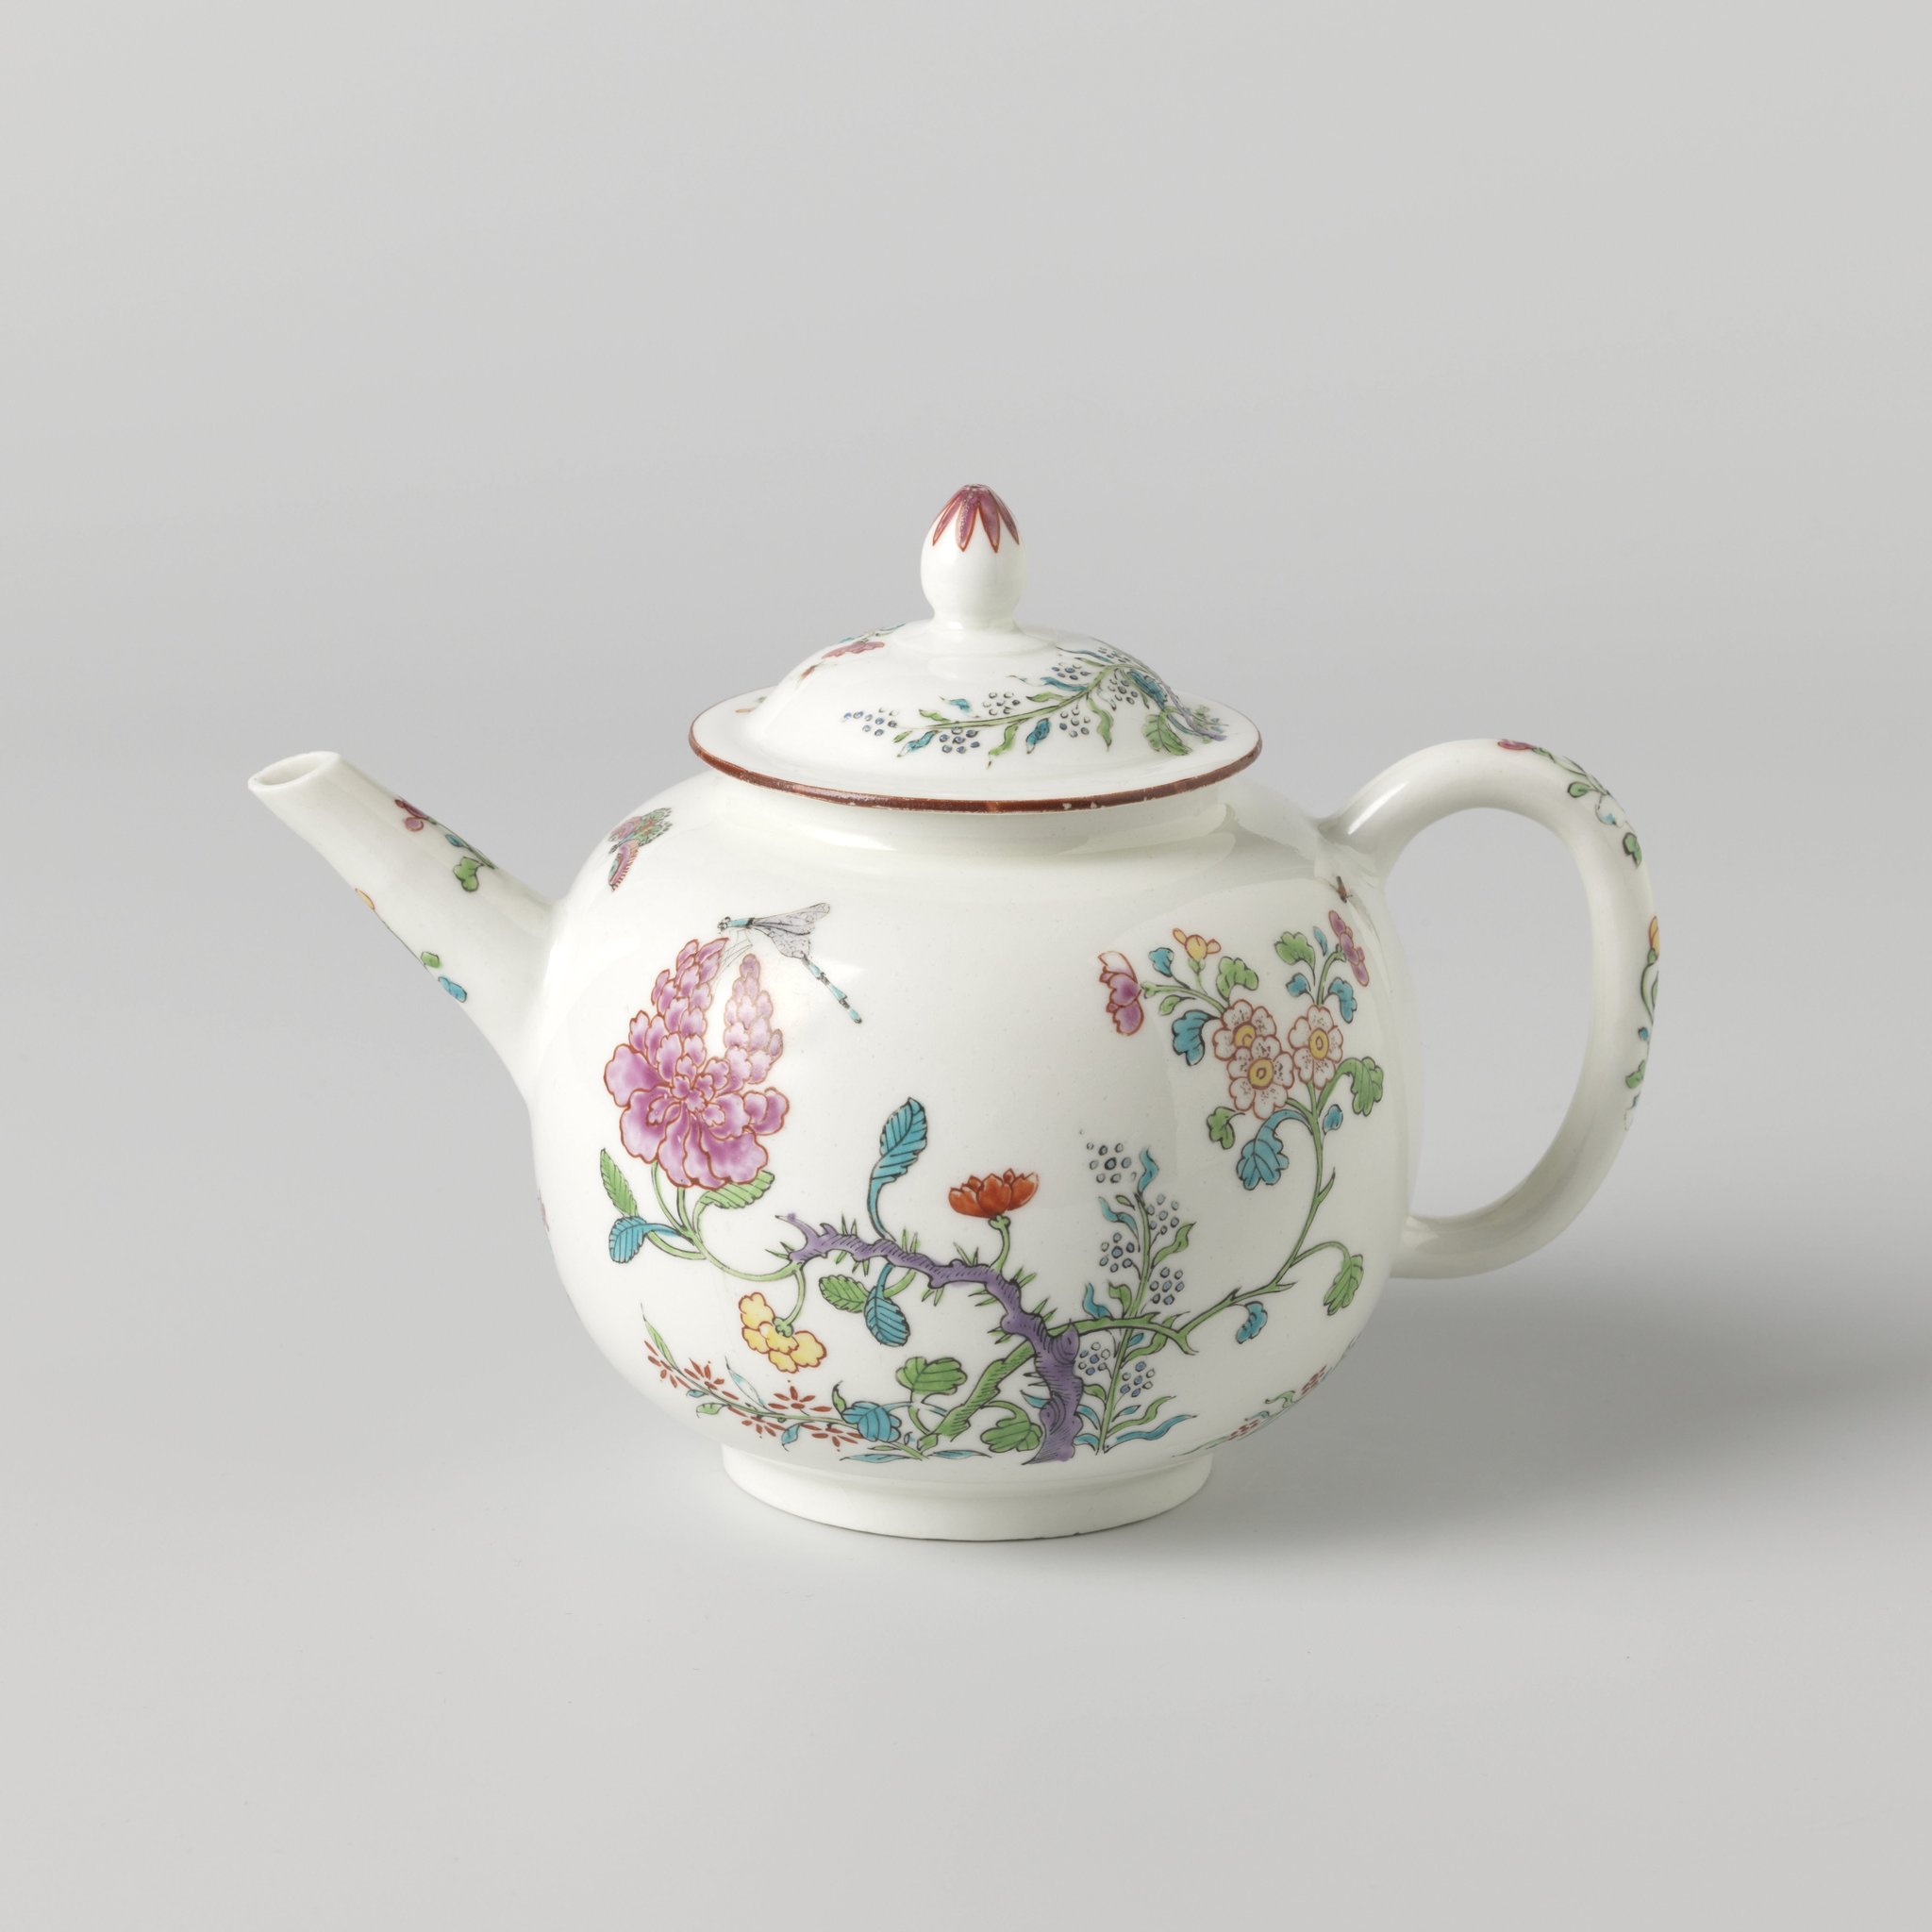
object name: eating drinking utensil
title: Deksel van een theepot, veelkleurig beschilderd met bloeiende takken en insekten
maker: Anonymous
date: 1720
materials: porcelain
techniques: painted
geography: netherlands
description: Deksel van beschilderd porselein, beschilderd met bloeiende takken en insekten. Op de knop van het deksel is een rose rozet geschilderd en langs de rand van het deksel een bruine bies.